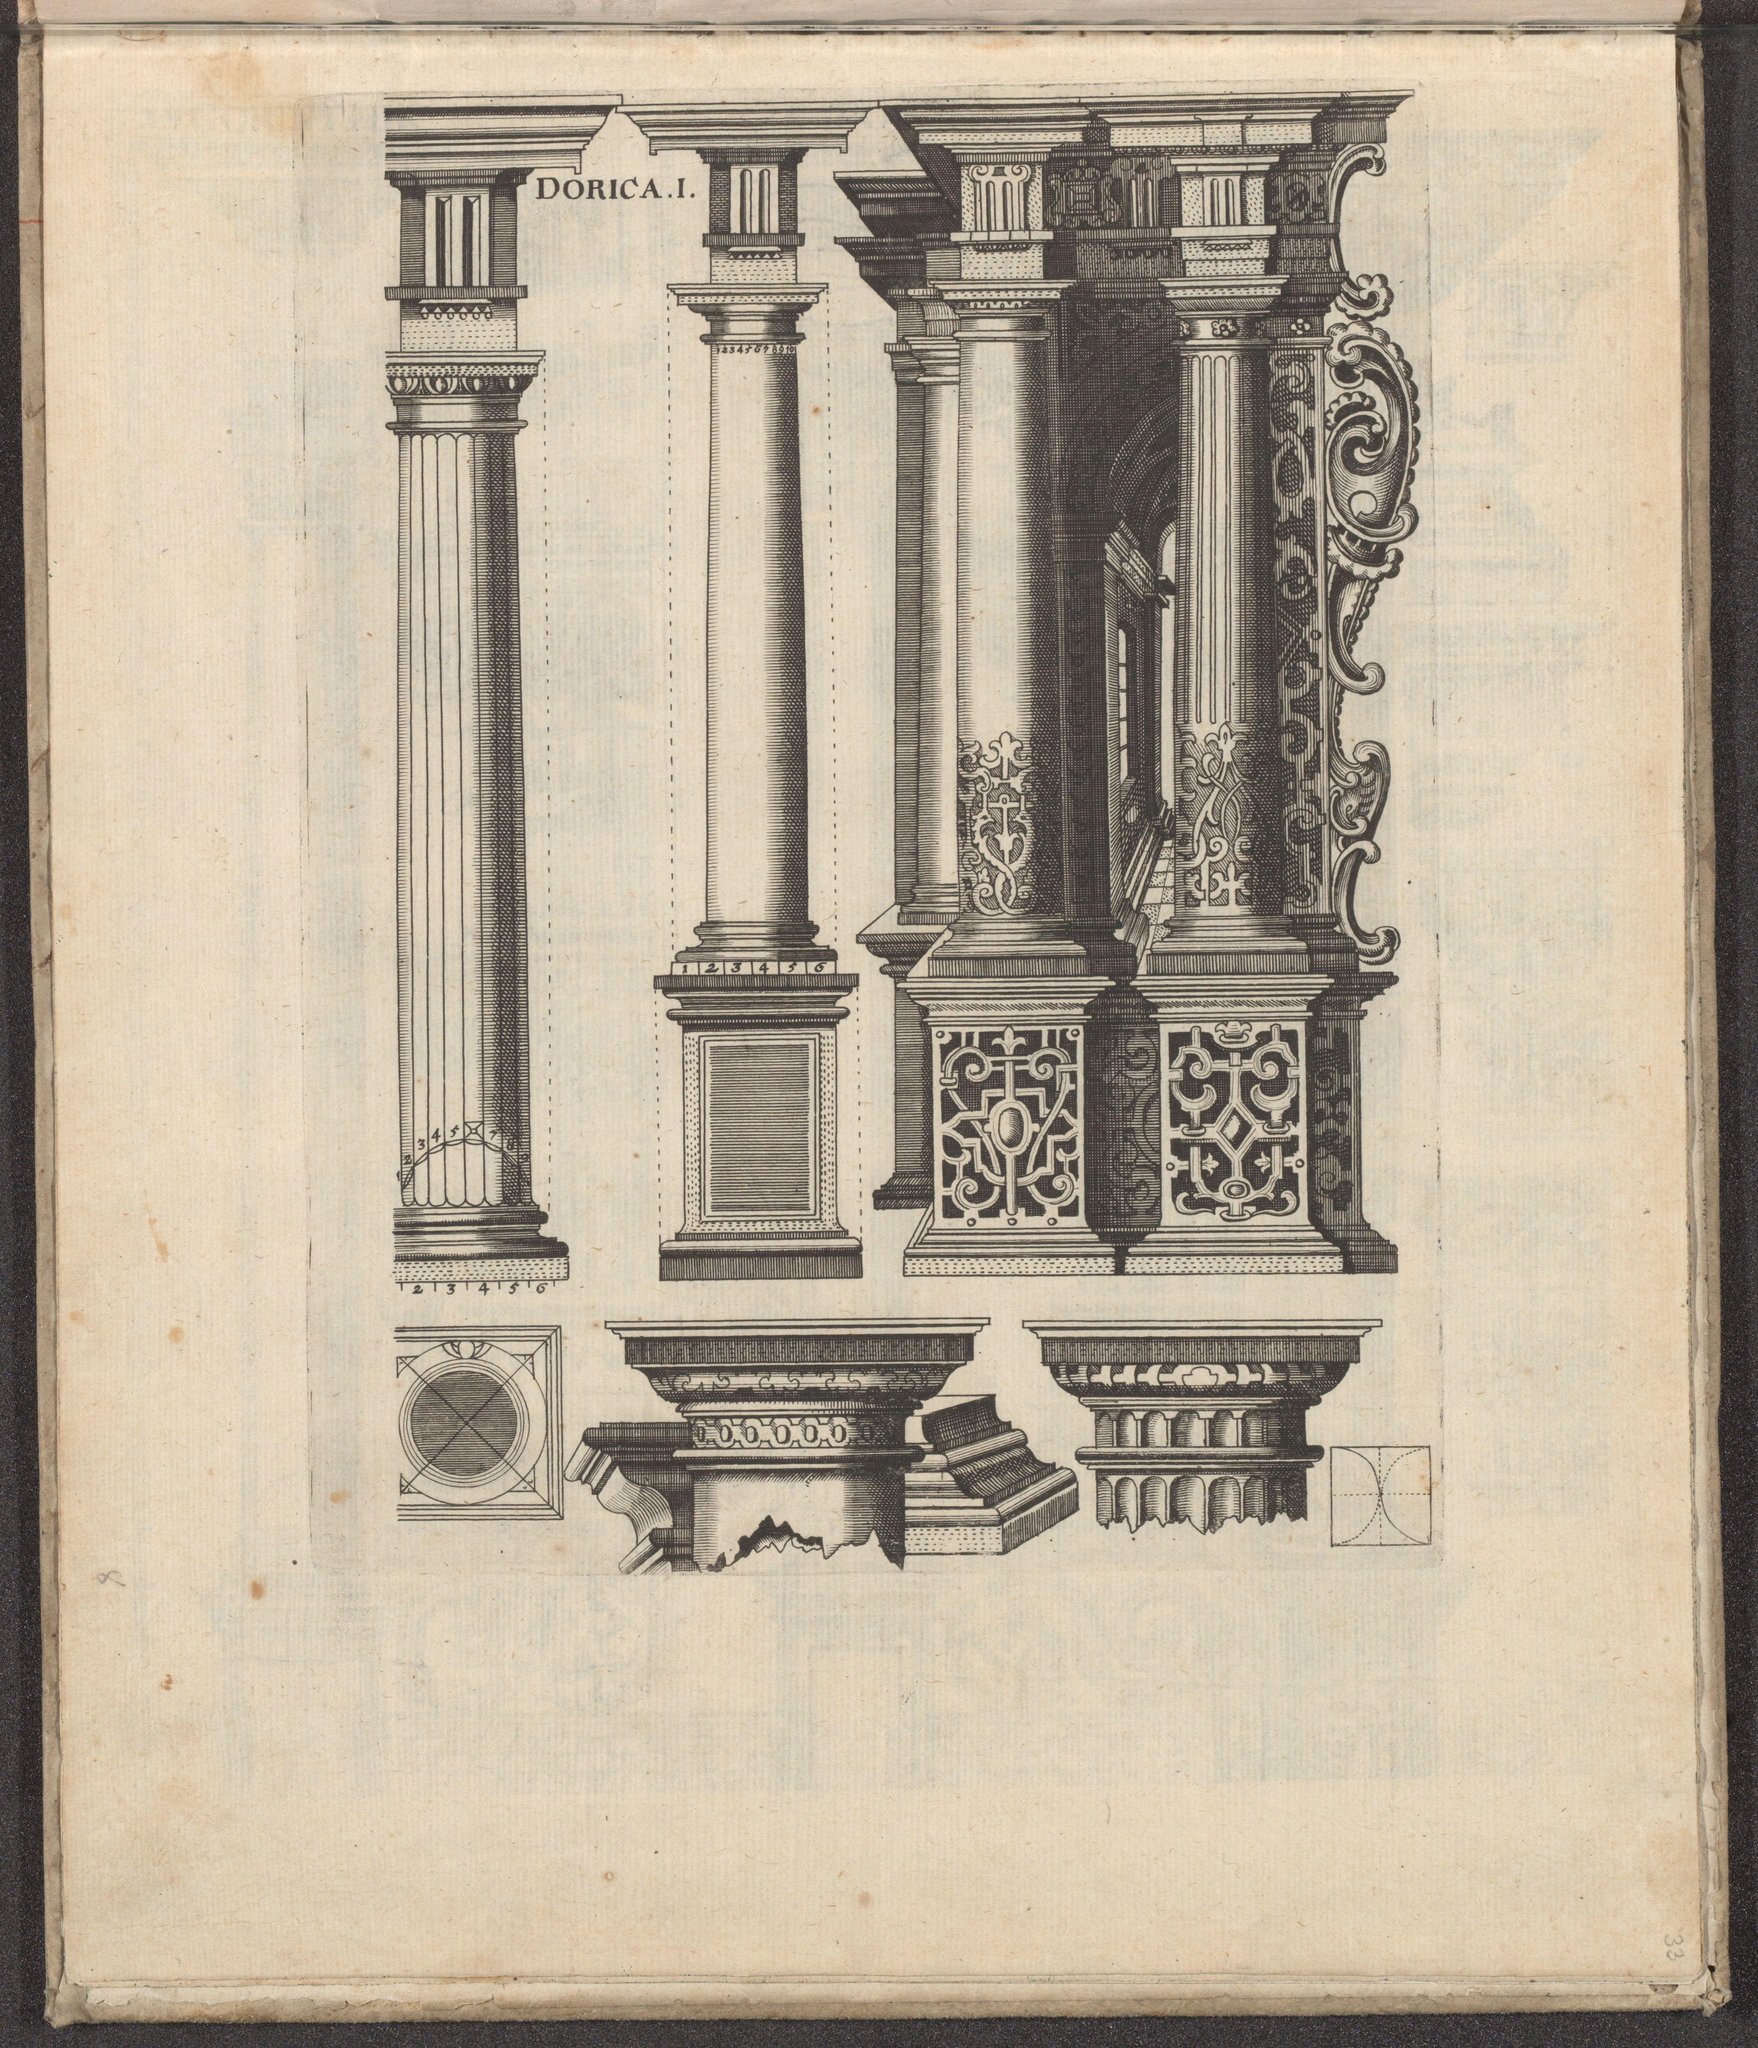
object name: album leaf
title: Fünf Ordnungen der Architektur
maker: johann christoph feinlein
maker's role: furniture worker, print maker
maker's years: 1620-1685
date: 1630-1685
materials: paper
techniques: engraving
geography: germany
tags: auricular ornament, lobe style ~ ornament, column, pillar ~ architecture, doric order ~ architecture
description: Vier voorbeelden van zuilen van de Dorische orde. Drie zuilen staan op een voet. Twee zuilen met cannelures. Onderaan een basement, twee kapitelen etc. Rechts enkele ornamenten in kwabstijl. De prent maakt deel uit van een album.